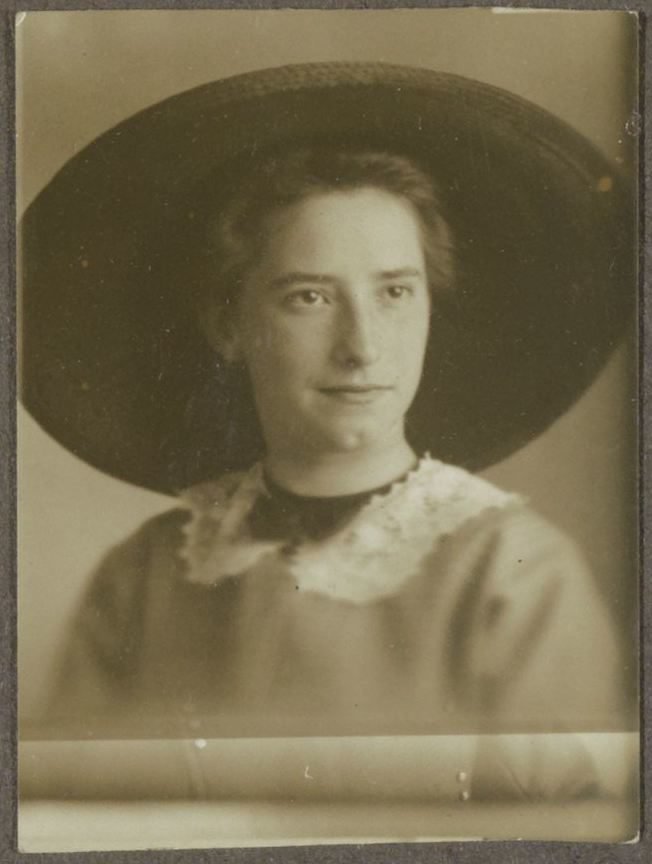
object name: photograph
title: Portret van een vrouw met een hoed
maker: Anonymous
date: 1920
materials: cardboard, paper, photographic support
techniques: gelatin silver print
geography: netherlands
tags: adult woman, historical persons, head-gear: hat, netherlands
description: Onderdeel van Fotoalbum met portretten vervaardigd door Nederlandse studio's waaronder automaatfoto's.